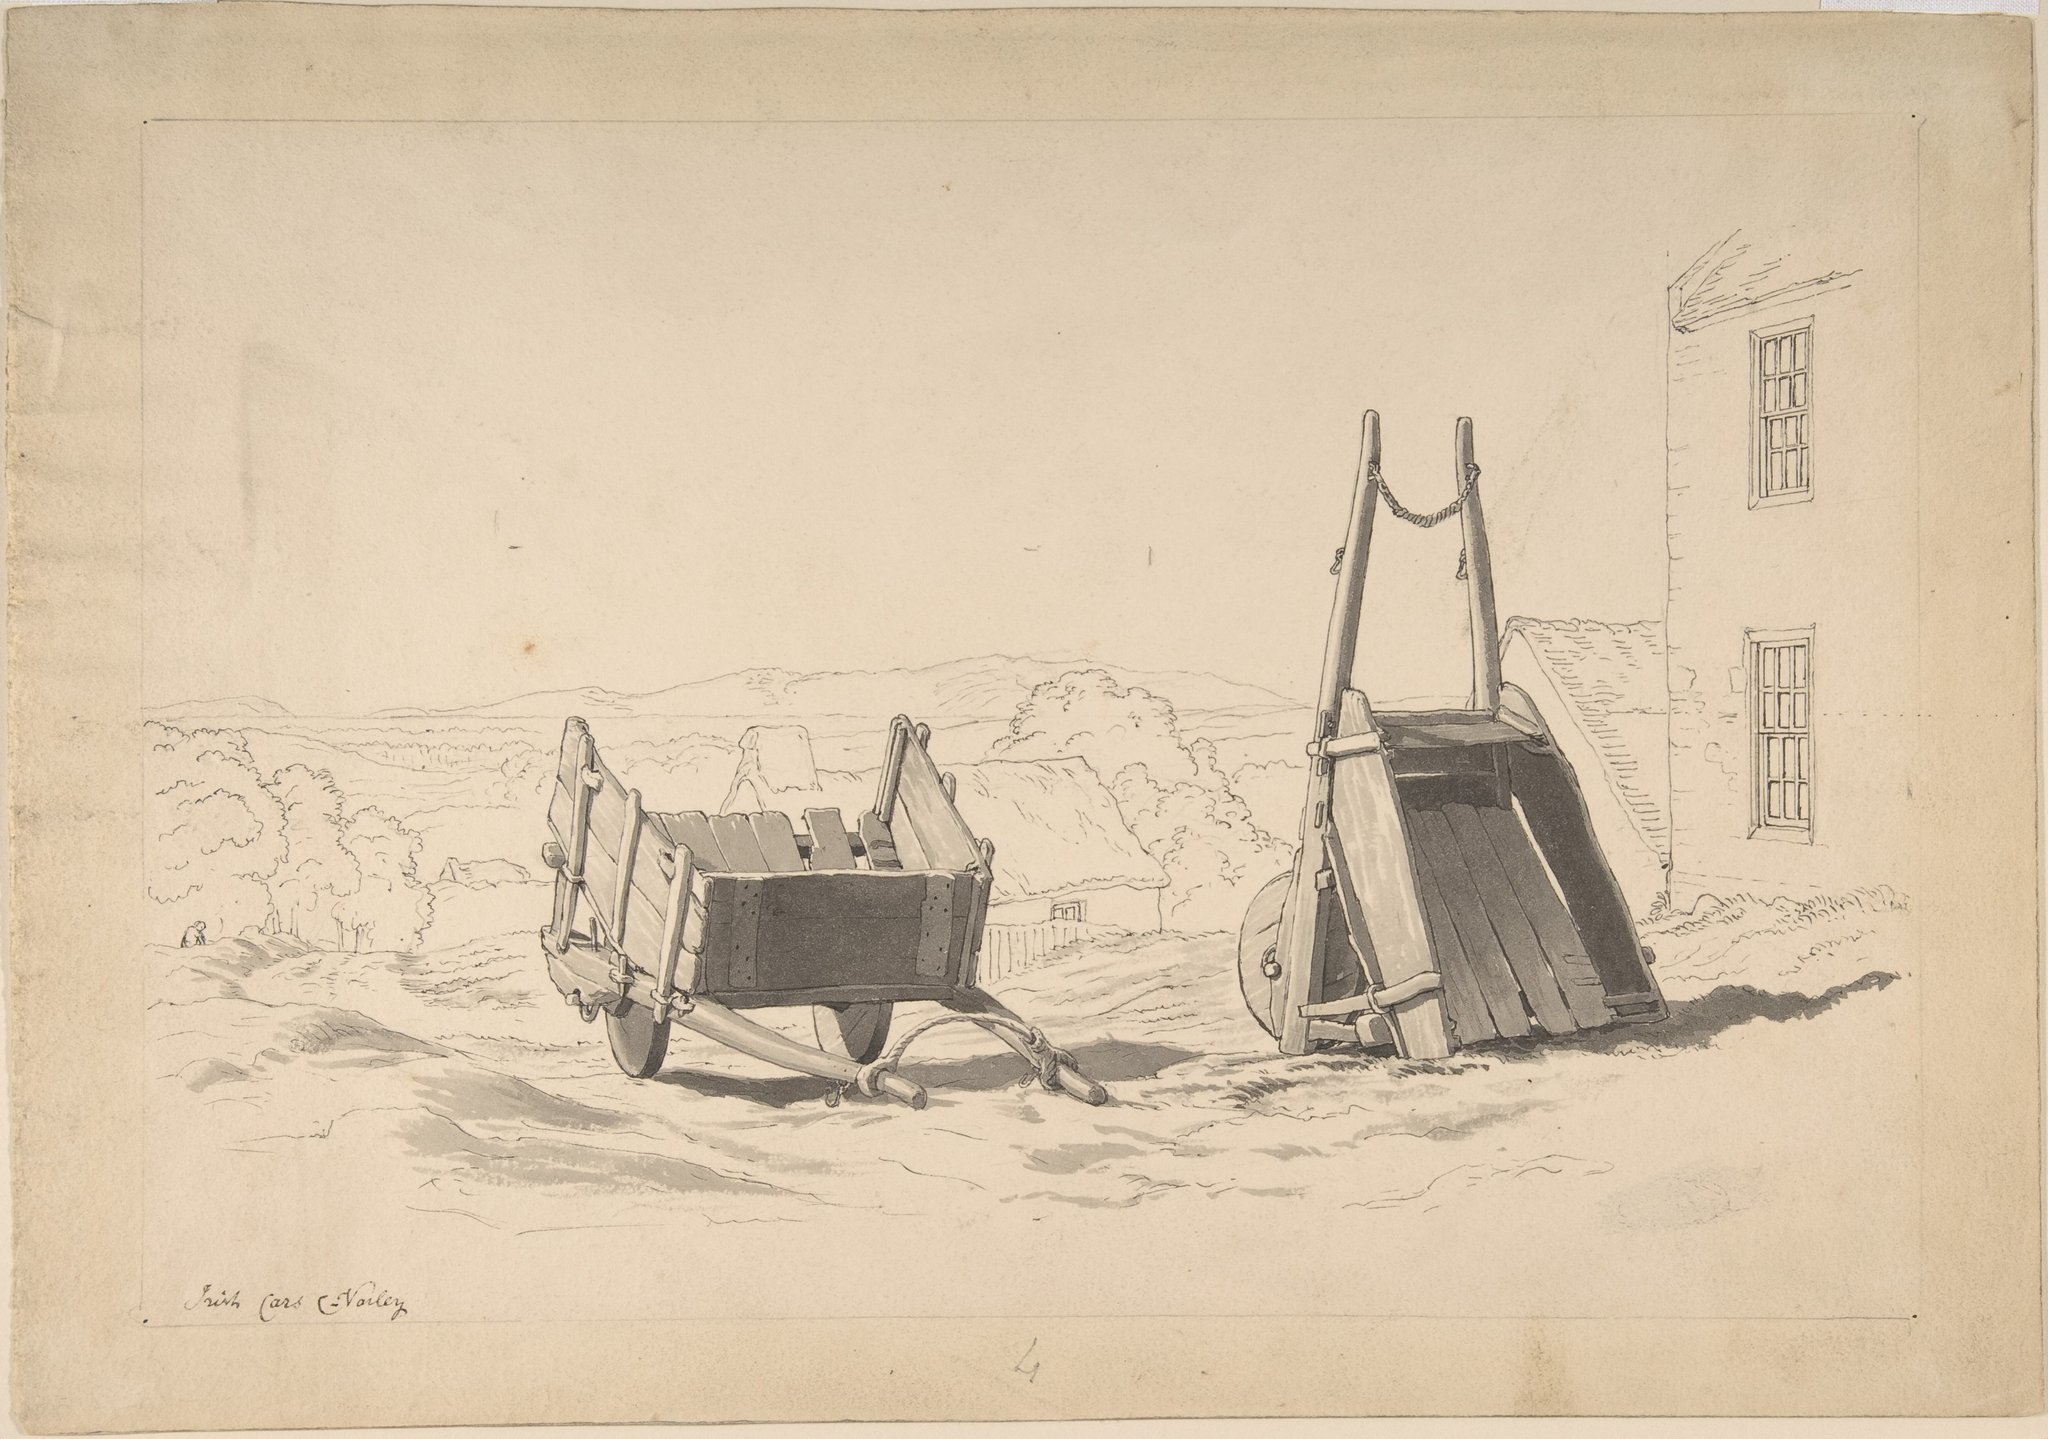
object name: drawing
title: Irish cars (Study of two carts in a landscape)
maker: cornelius varley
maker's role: artist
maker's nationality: british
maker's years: 1781-1873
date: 1800-1873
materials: graphite, ink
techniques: brush, pen, wash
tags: carts